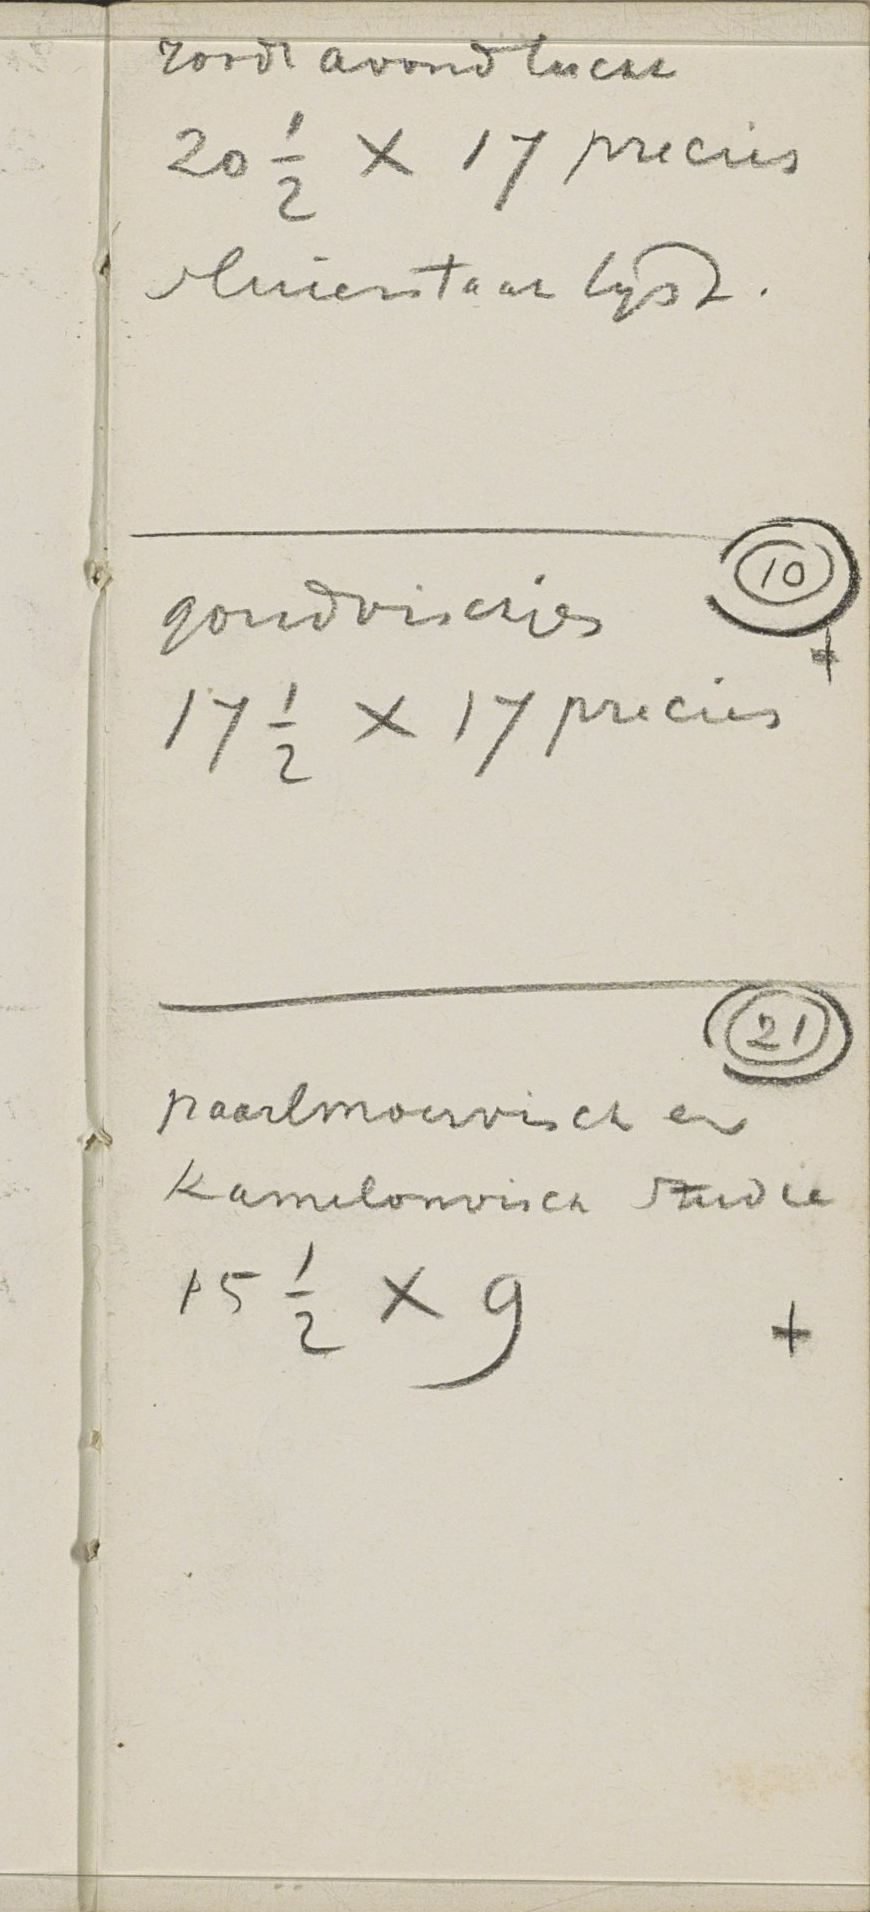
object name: sketchbook leaf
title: Notities over kunstwerken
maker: gerrit willem dijsselhof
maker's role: designer, draughtsman, print maker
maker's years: 1866-1924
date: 1876-1924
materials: chalk, paper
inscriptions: annotation: ‘roode avondlucht/ 20 1/2 x 17 precies/ sluierstaart lijst/ goudvischjes 10/ [...]’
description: Blad 2 recto uit een schetsboek met 40 bladen.